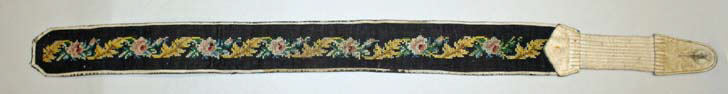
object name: suspender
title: Suspenders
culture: european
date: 1801-1900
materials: cotton, silk